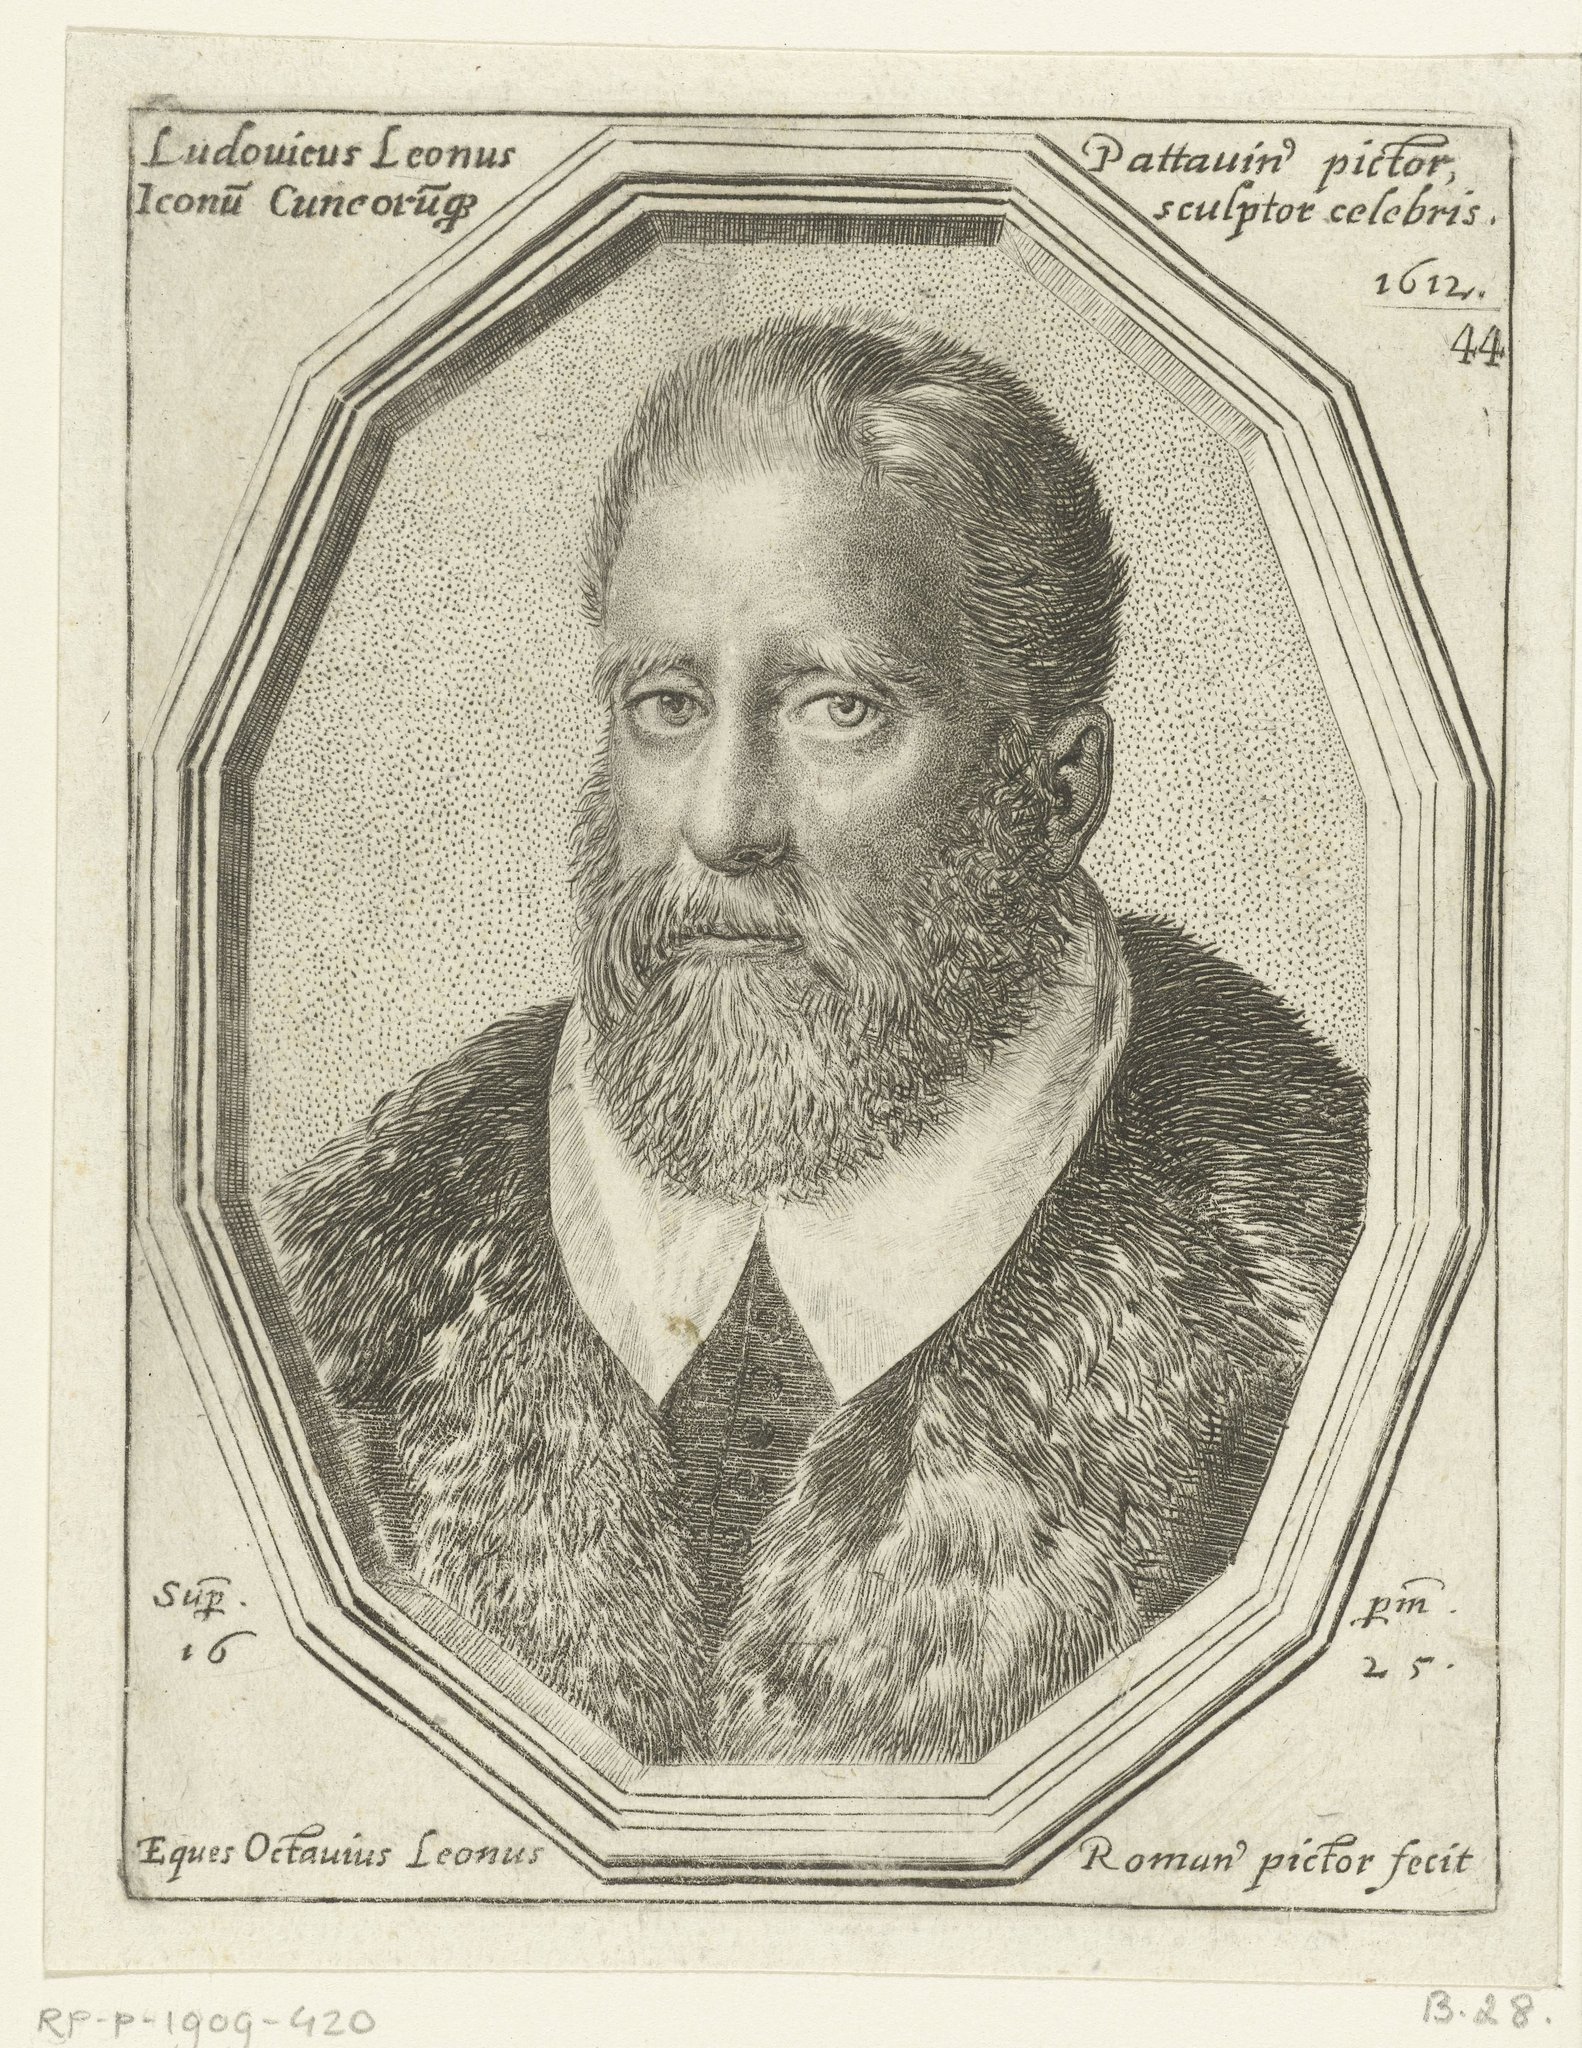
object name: print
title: Portret van Ludovico Leoni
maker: ottavio mario leoni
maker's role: draughtsman, print maker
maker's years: 1578-1630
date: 1625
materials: paper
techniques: etching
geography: italy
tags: rome, painter, sculptor, ludovico leoni, portrait, self-portrait of artist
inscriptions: collector's mark: Lugt 2228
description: Portret van de kunstenaar Ludovico Leoni, vader van de vervaardiger van de prent.